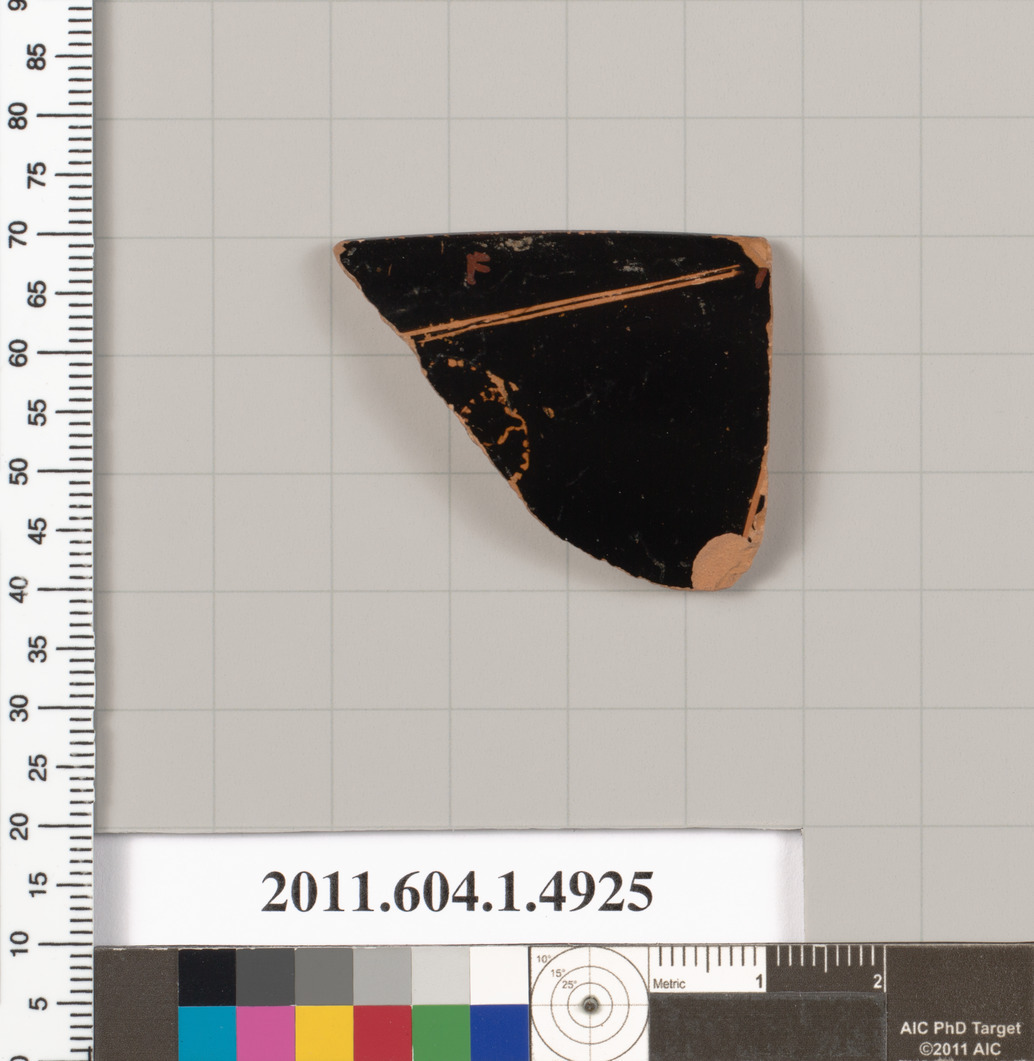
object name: kylix fragment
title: Terracotta rim fragment of a kylix (drinking cup)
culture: greek, attic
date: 520-500 BCE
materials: terracotta